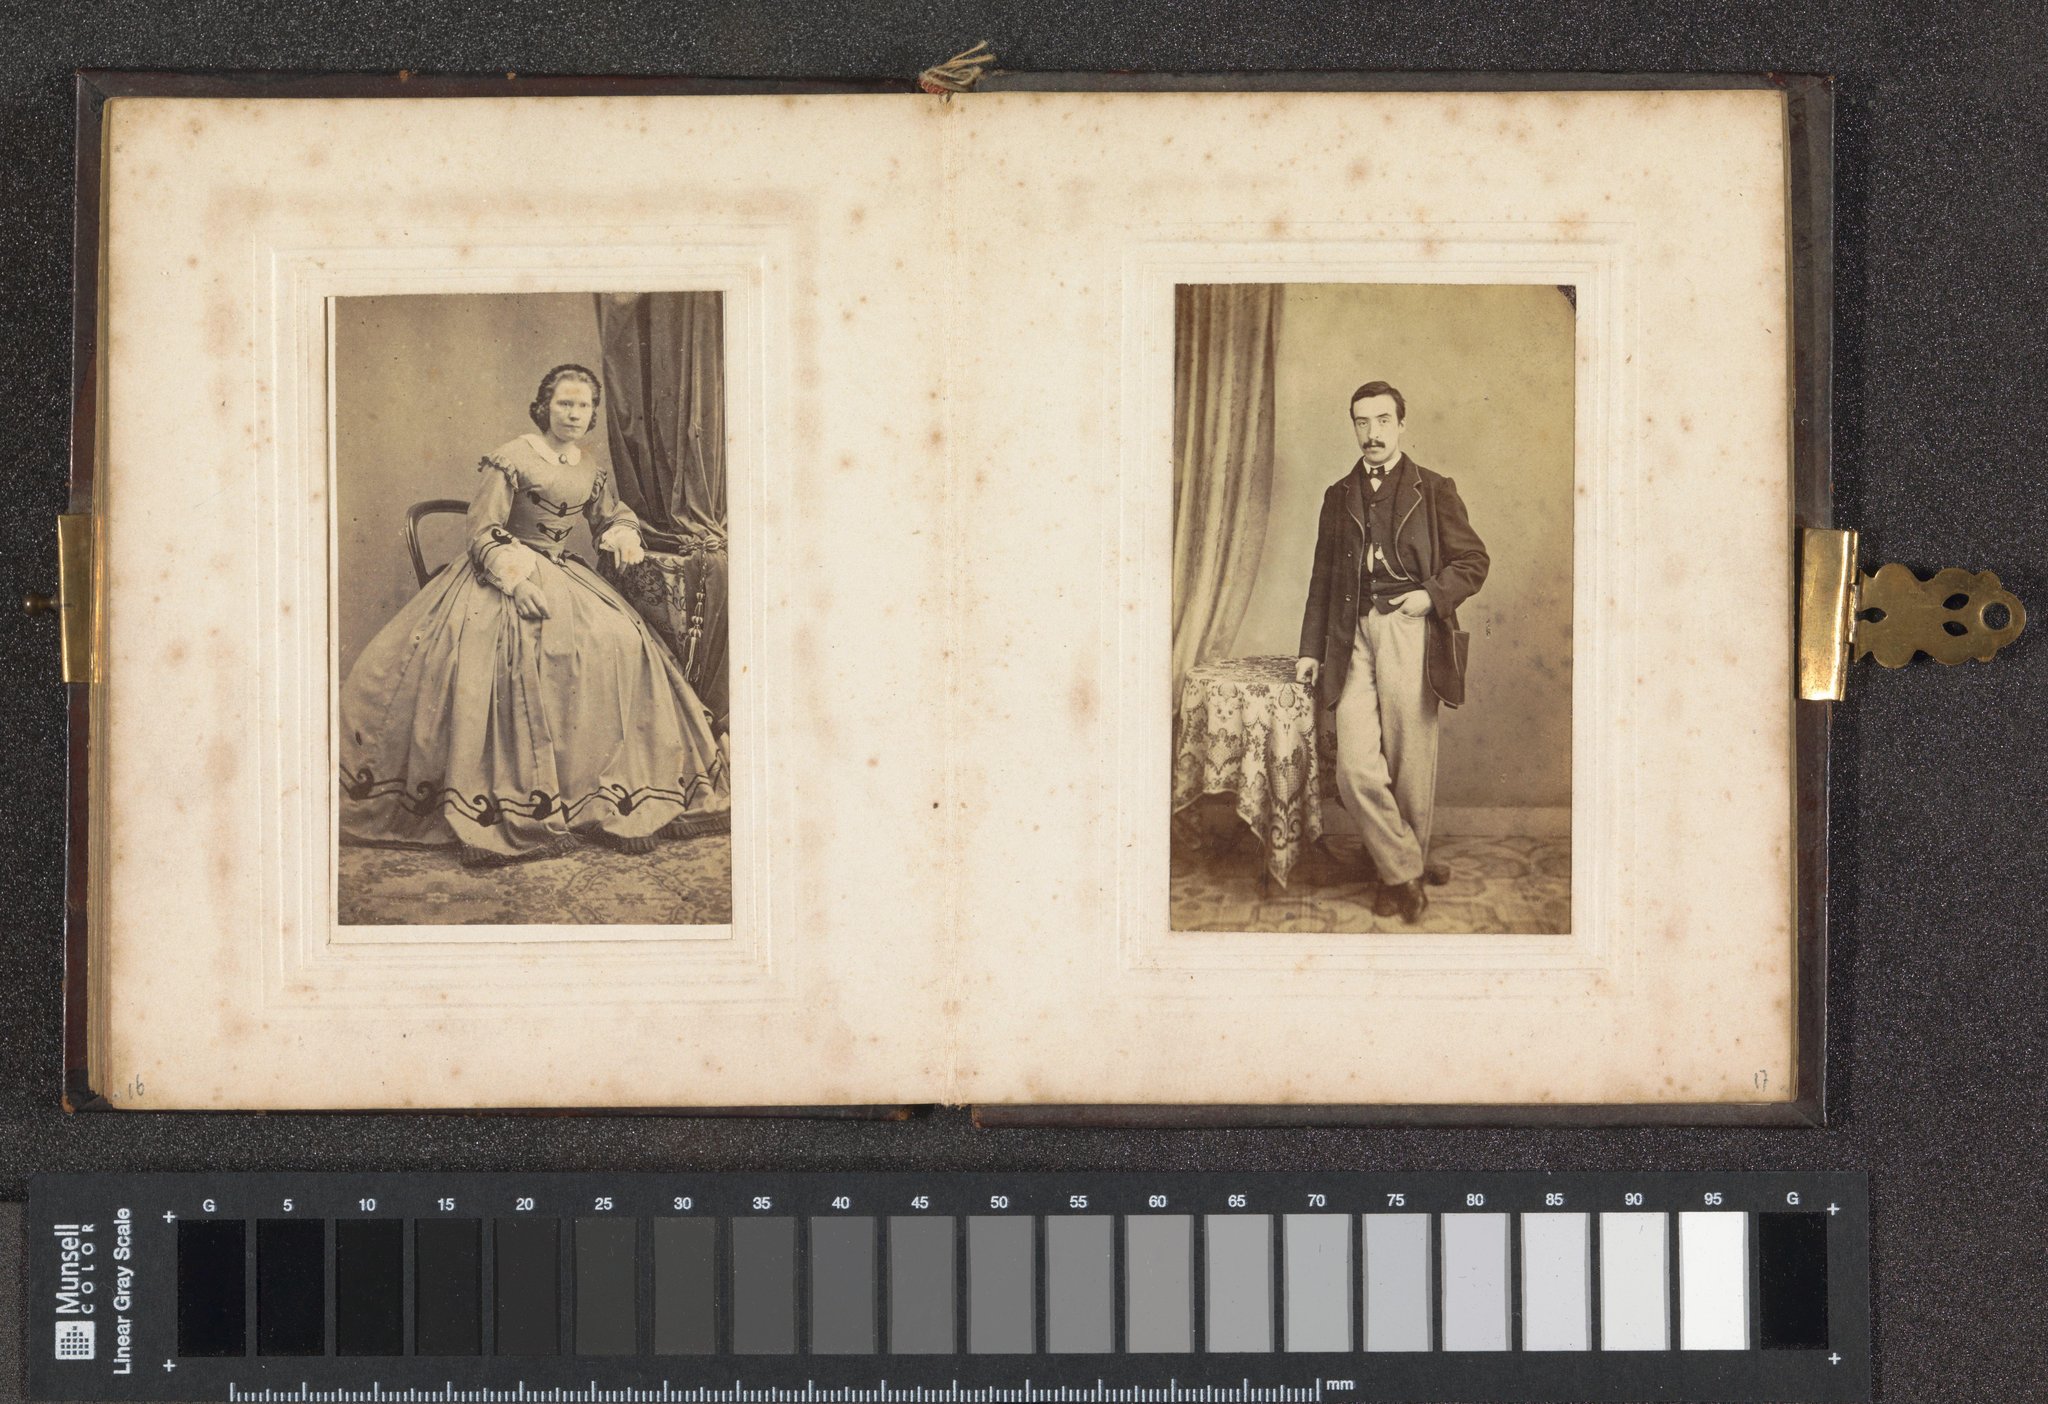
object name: carte de visite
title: Portret van een man in een driekwart jas, staand met een hand in de zak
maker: c. j. korsten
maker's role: painter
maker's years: 1829-1914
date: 1860-1875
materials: cardboard, paper, photographic support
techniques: albumen print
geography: zierikzee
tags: hand in the pocket, studio requisites ~ photographer, adult man, historical persons, family life, coat, cape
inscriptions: name: ‘C.J. Korsten Phot.’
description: Onderdeel van Fotoalbum met cartes-de-visite van een Zeeuwse familie.